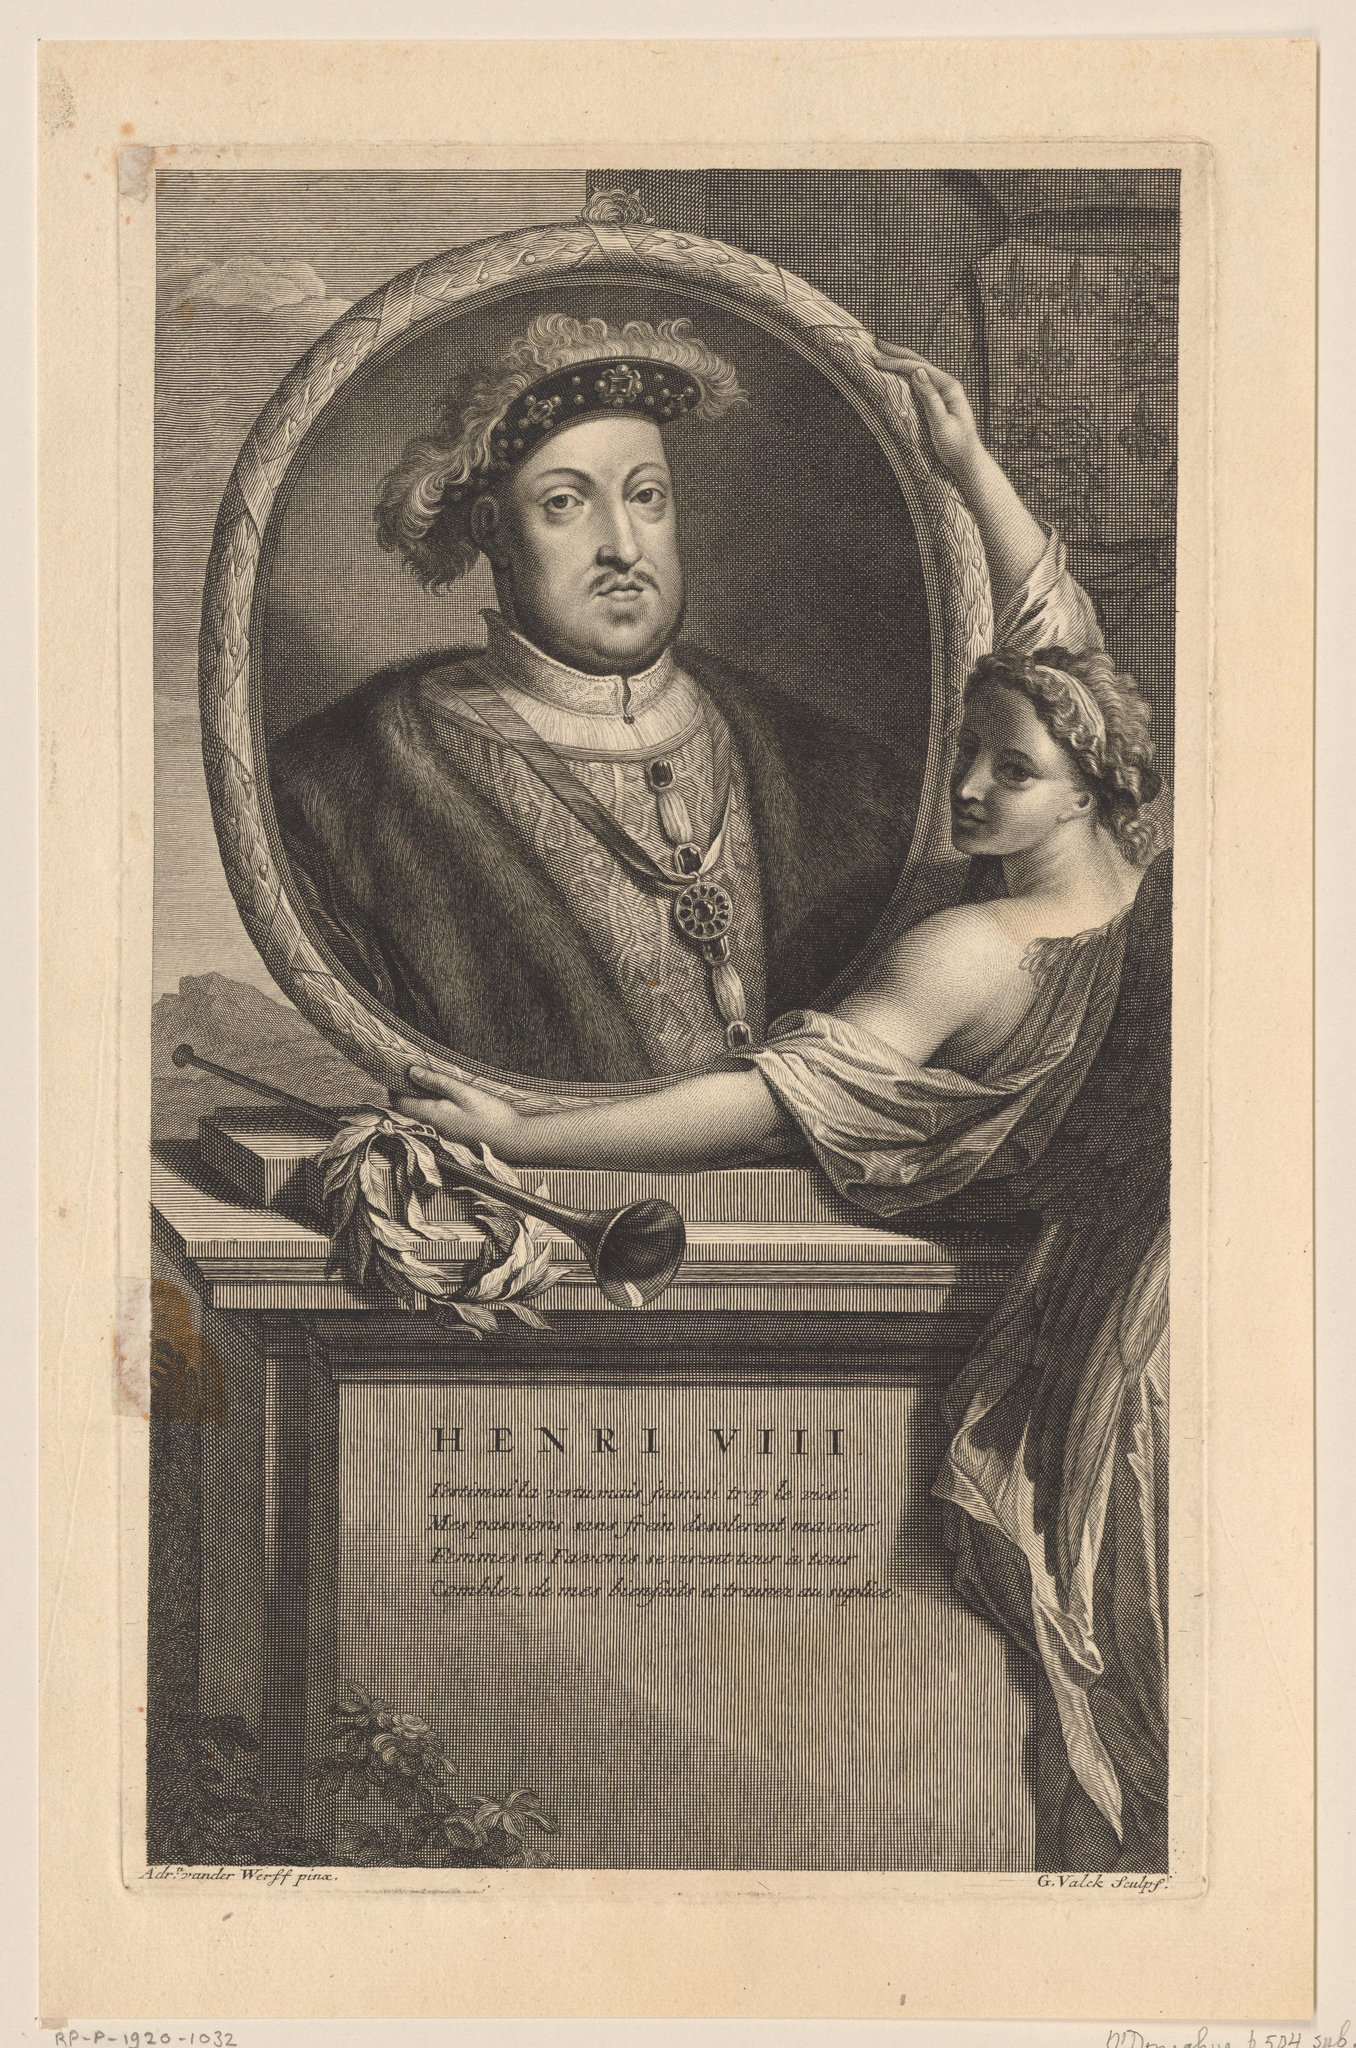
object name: print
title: Portret van Hendrik VIII, koning van Engeland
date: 1670-1726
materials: paper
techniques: engraving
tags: historical persons, king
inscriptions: collector's mark: Lugt 2228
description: Prent gebruikt in: Larrey, Isaac de. Histoire d'Angleterre, d'Ecosse, et d'Irlande. Rotterdam: Reinier Leers, 1697.